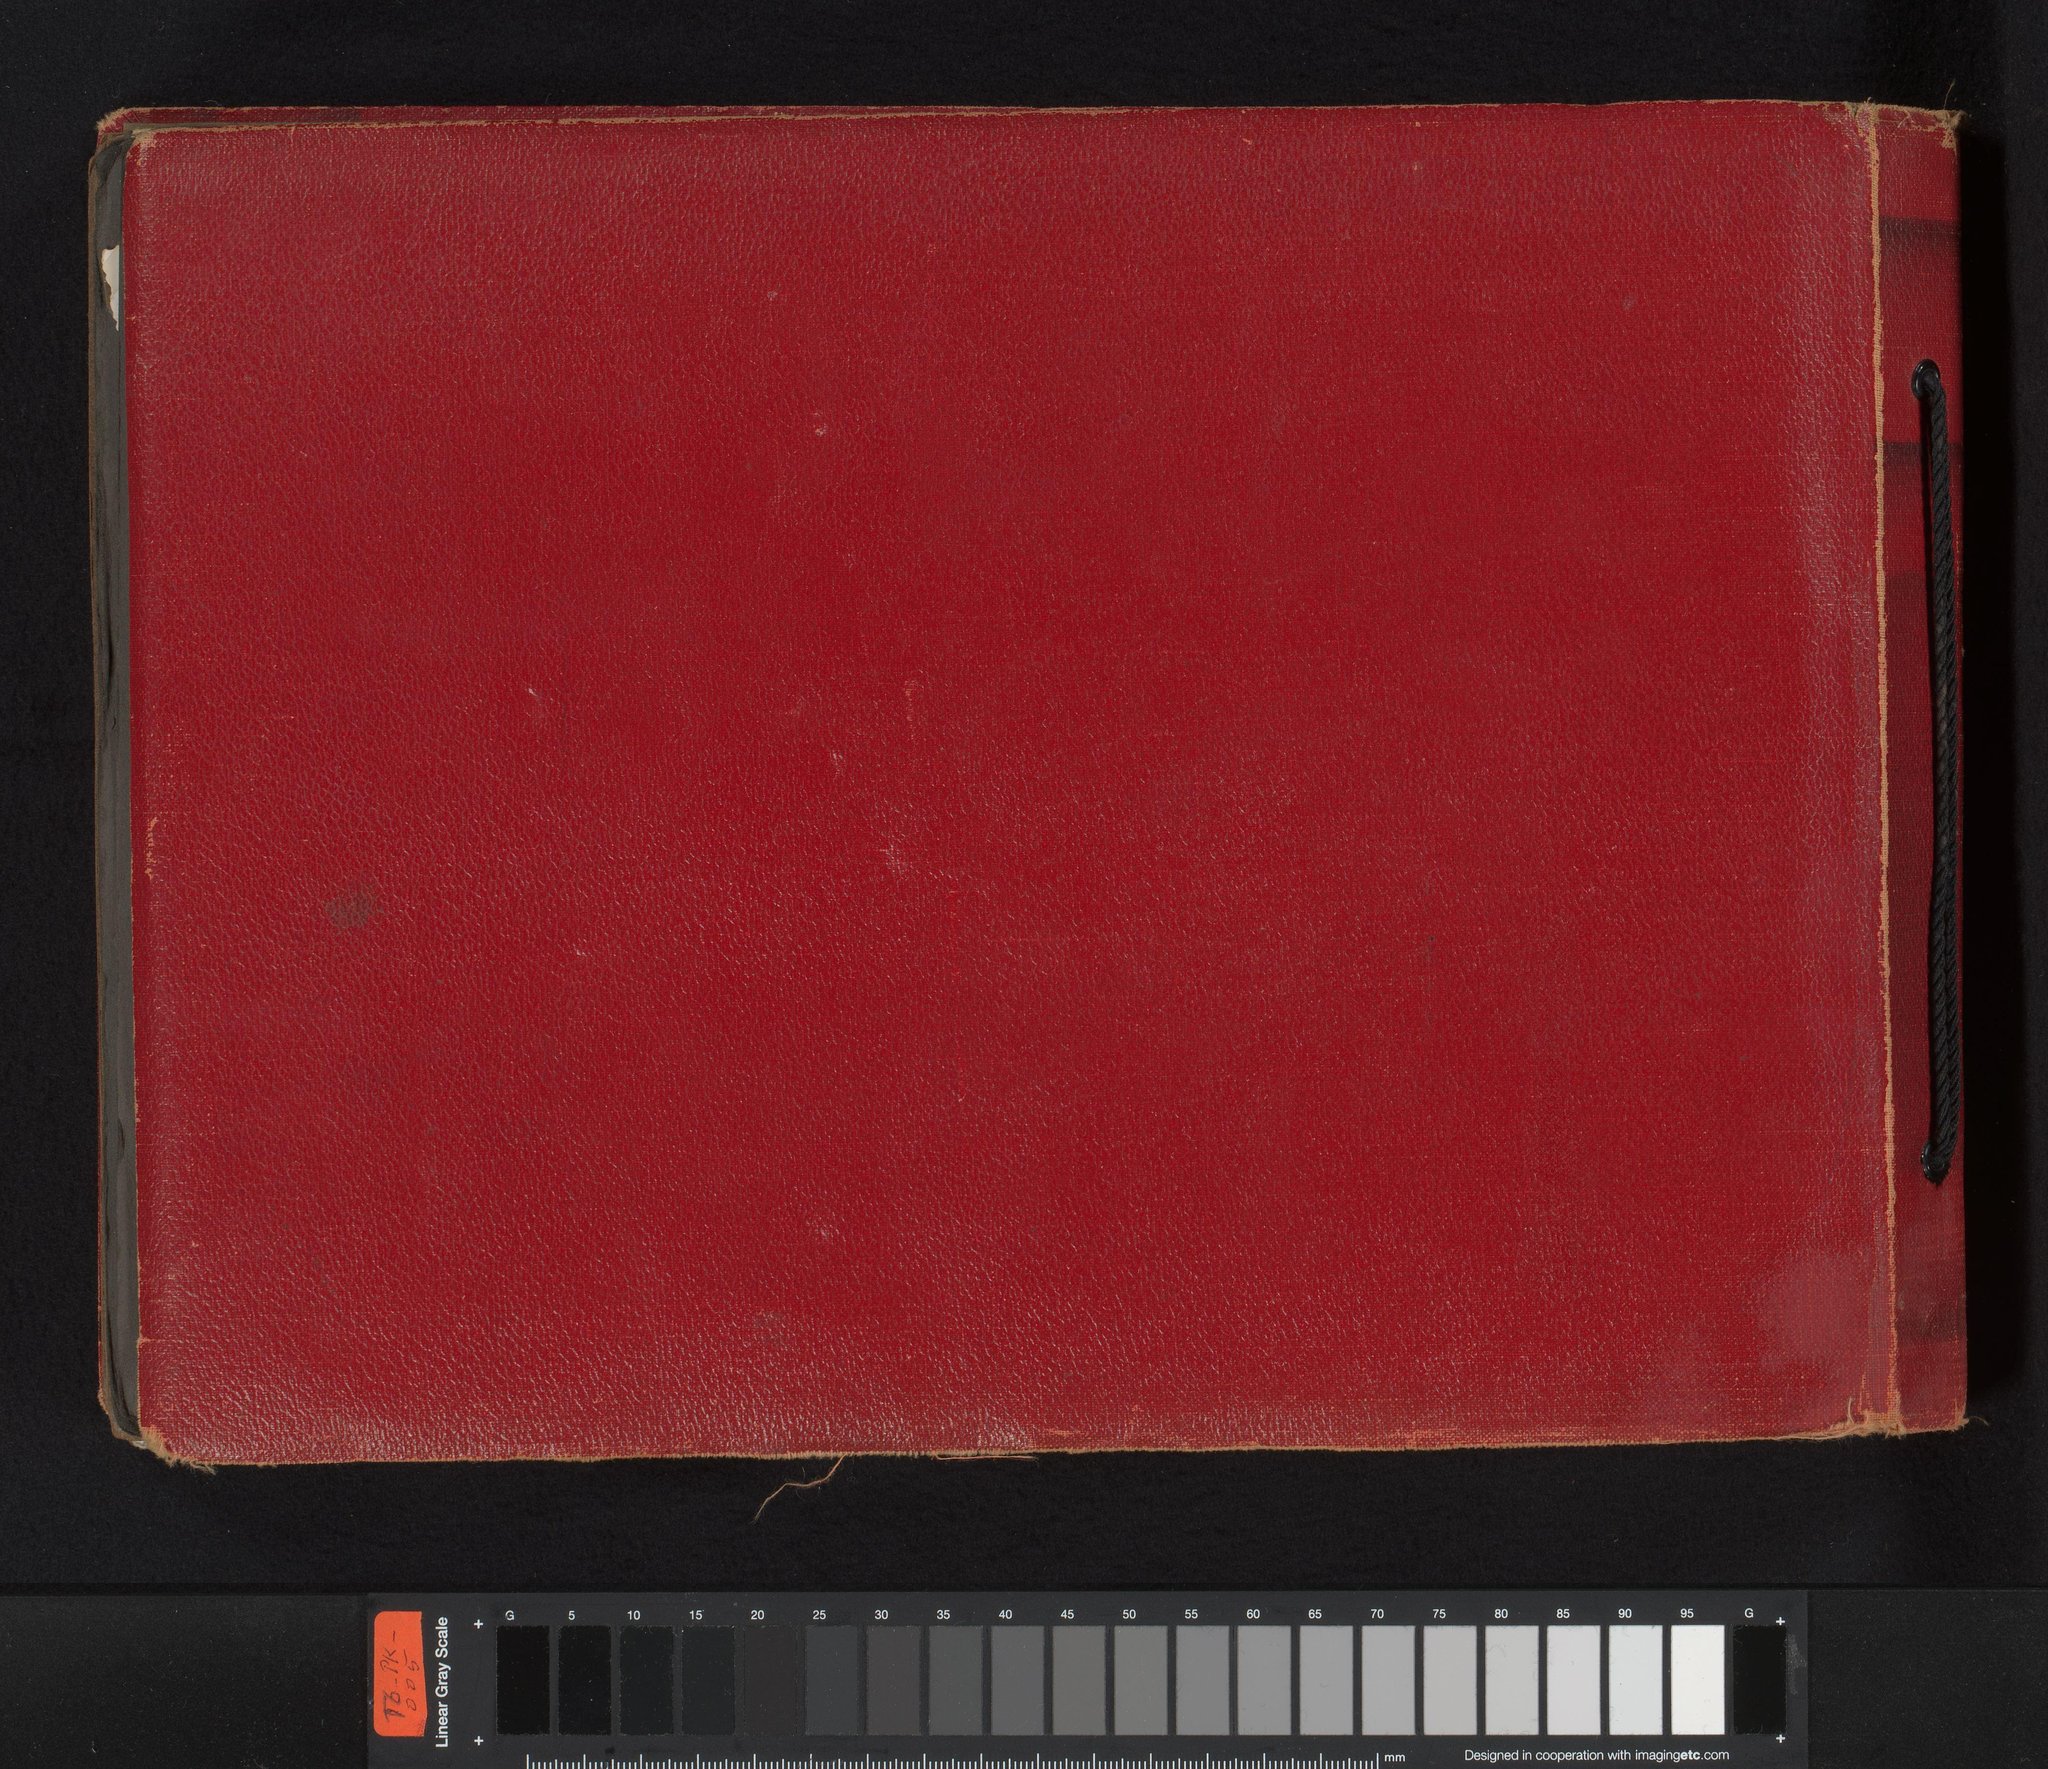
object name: photograph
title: 10de dag Stuttgart-Koblenz / 11de dag Koblenz-Utrecht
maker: Anonymous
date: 1908-1937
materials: paper, photographic support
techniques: gelatin silver print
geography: germany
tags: customs, outing, pleasure trip, cologne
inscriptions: inscription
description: Albumblad met drie foto's van de reisgroep en een plattegrondje van Stuttgart. Verslag van een elfdaagse groepsreis per autobus naar Zwitserland van 2 tot en met 12 augustus 1937. Onderdeel van het reisalbum van de familie Van den Broek 1935-1937.